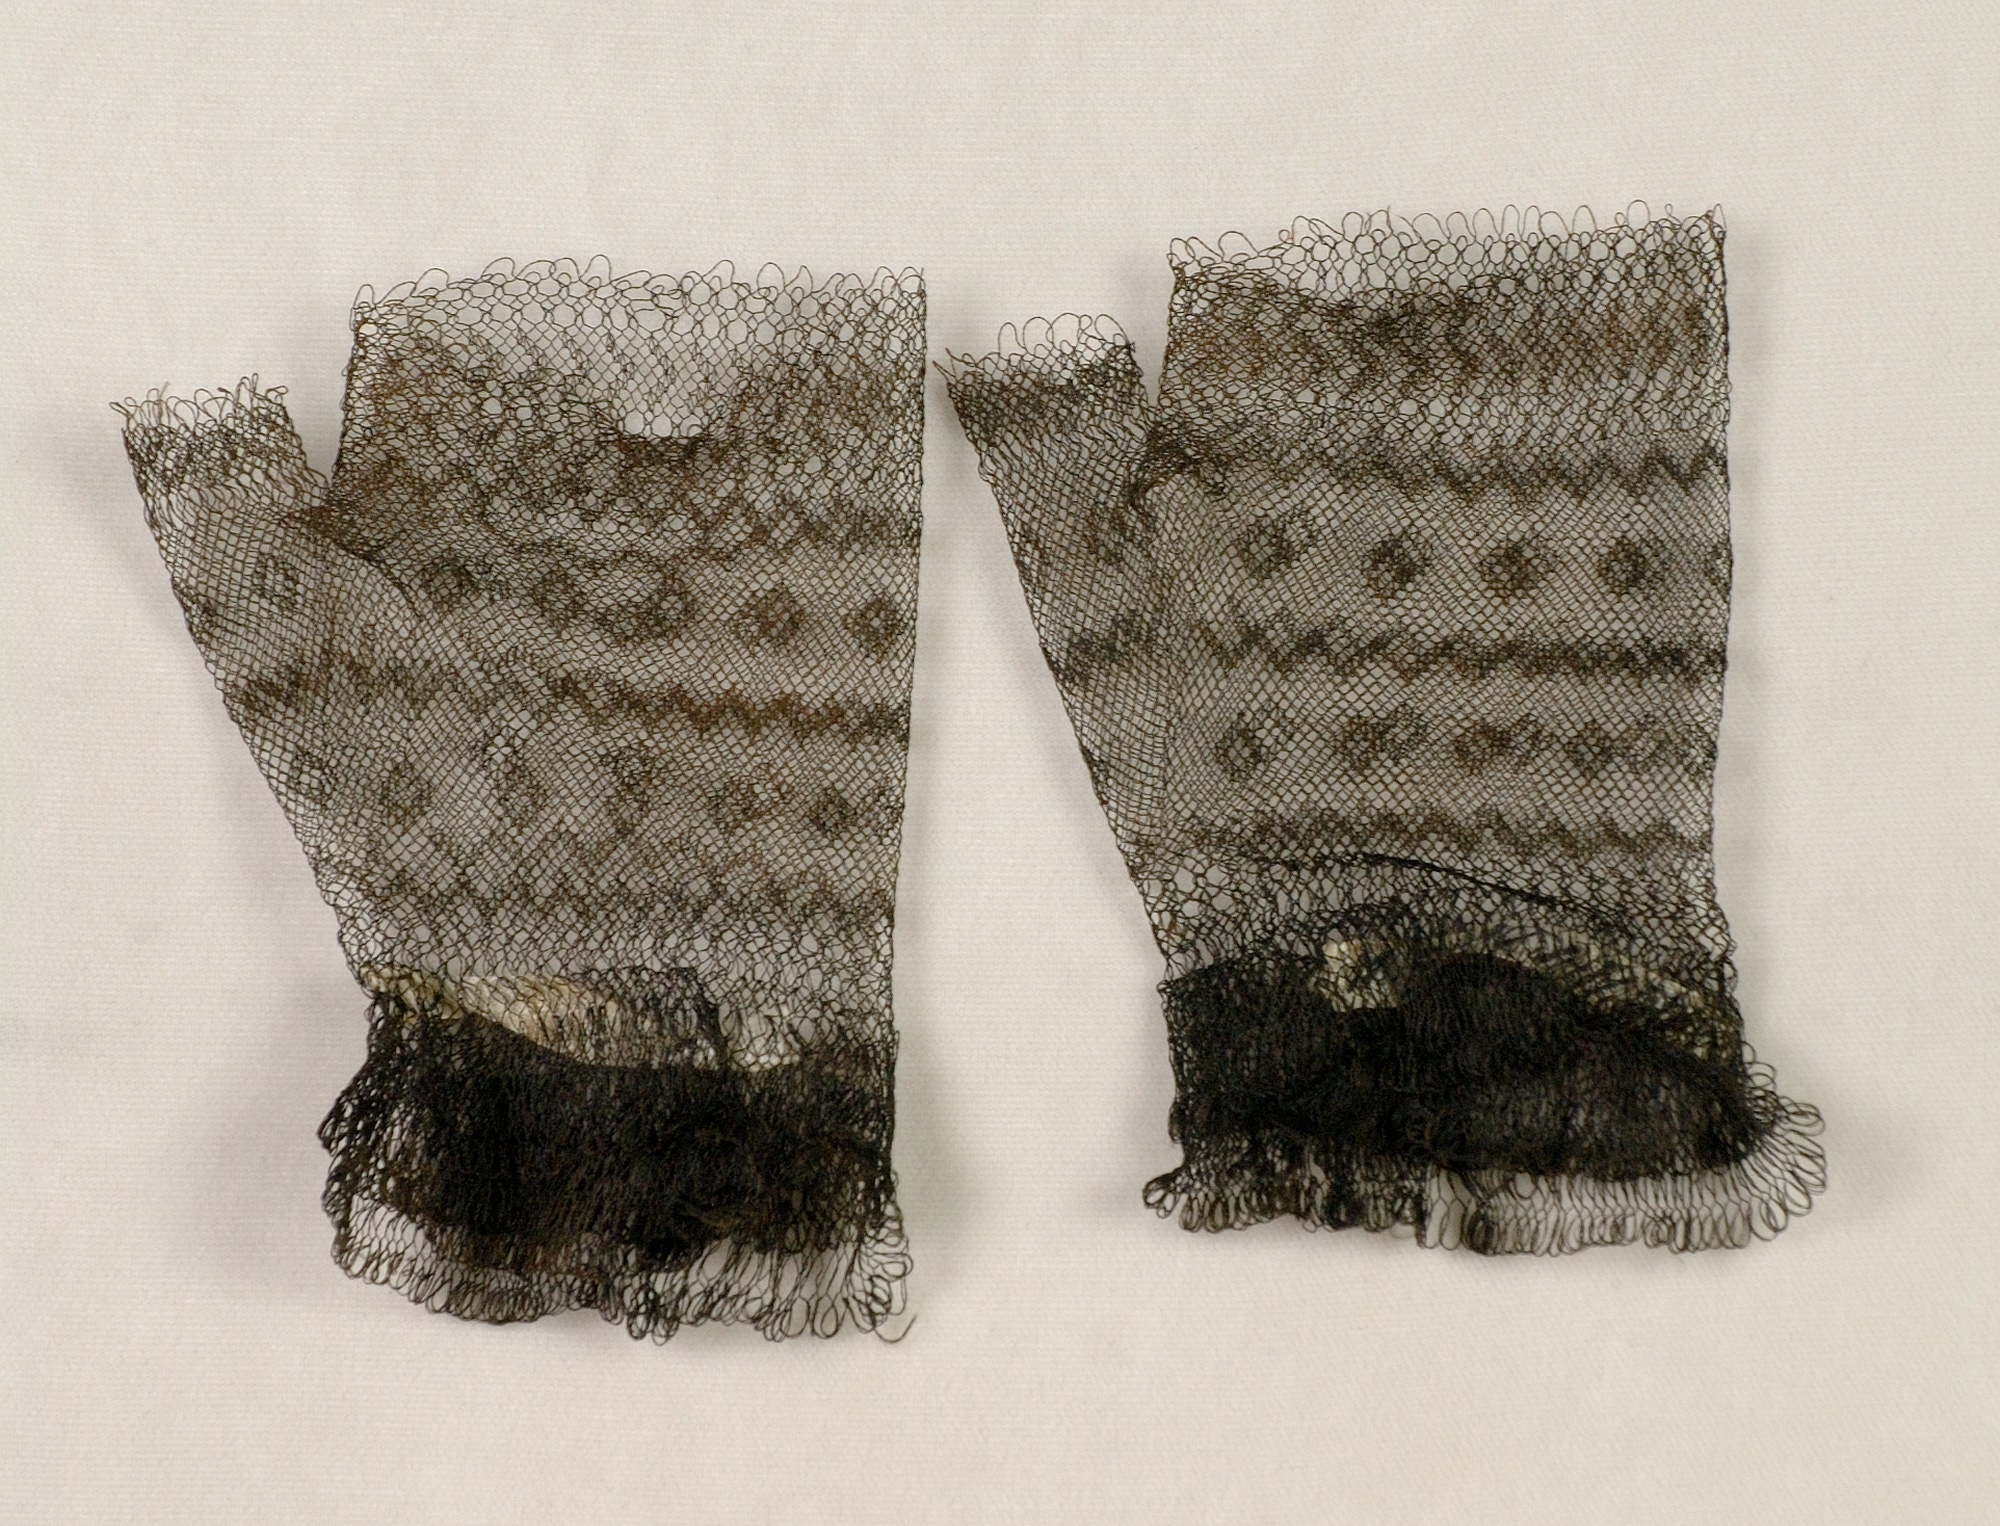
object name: mitt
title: Mitts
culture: american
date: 1851-1875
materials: silk